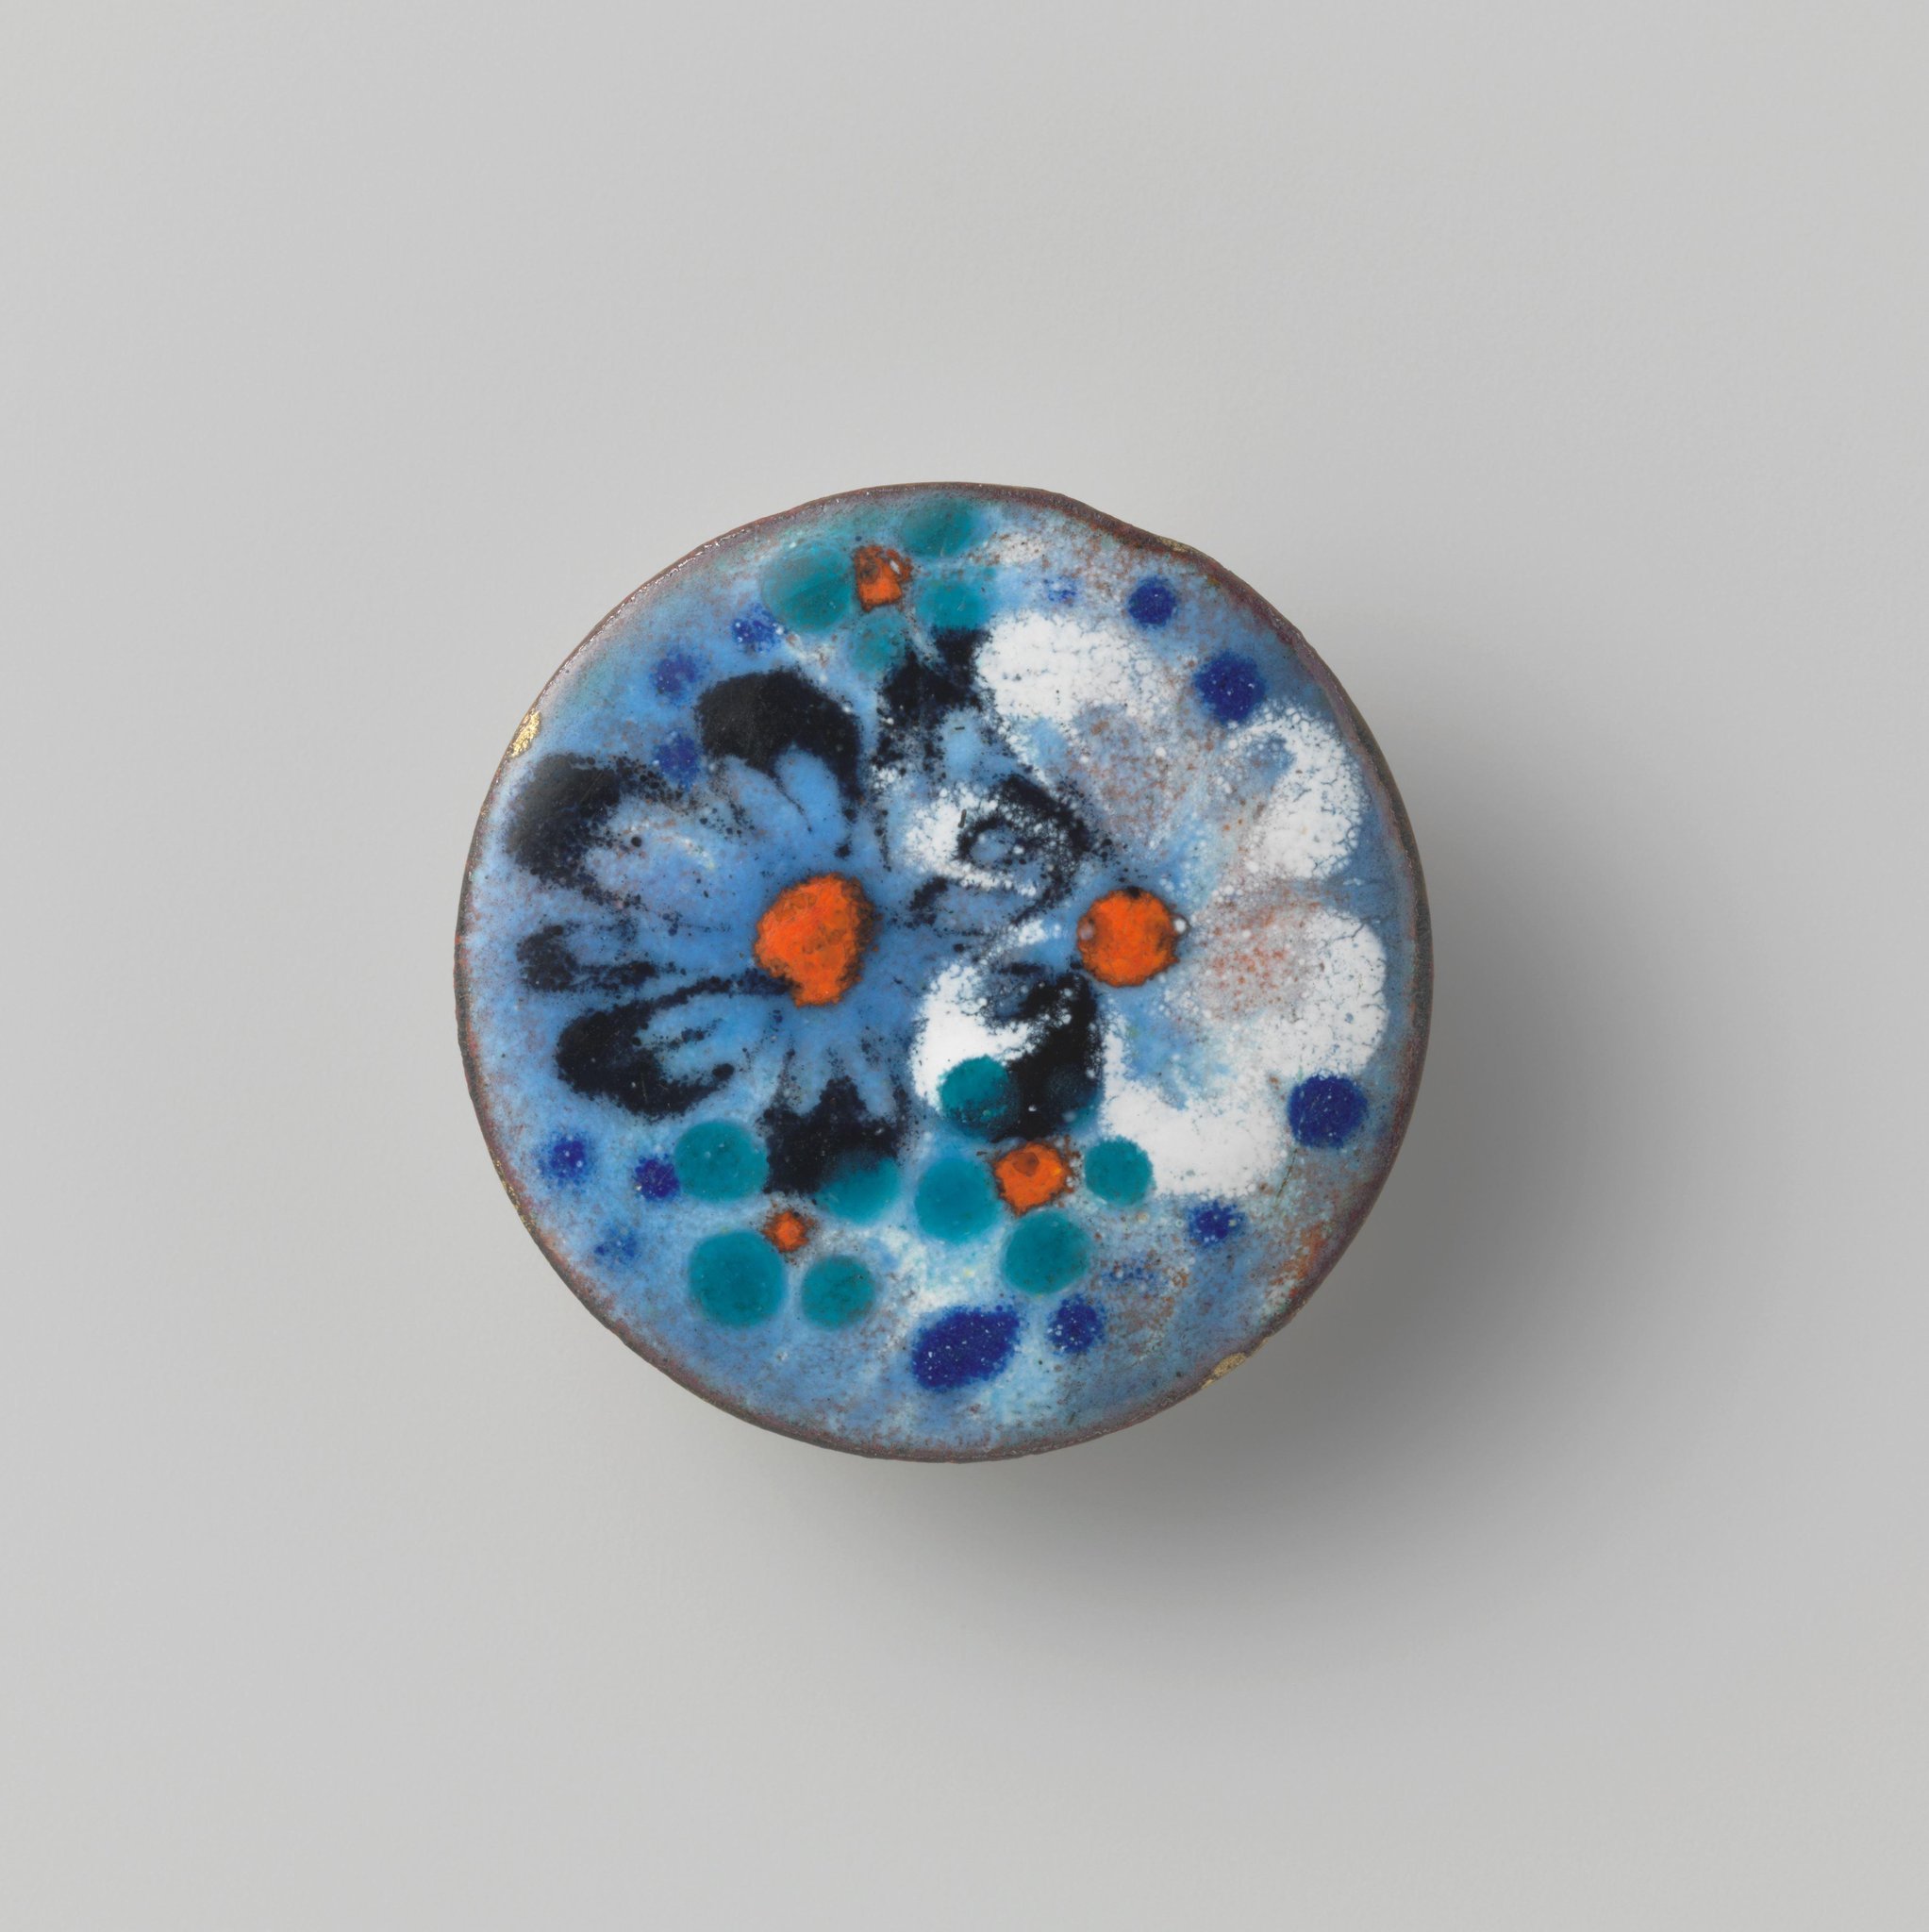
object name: brooch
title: Ronde broche van email op koper met bloemen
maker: Anonymous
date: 1950-1960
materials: copper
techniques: enameling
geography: netherlands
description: Ronde broche van email op koper voorzien van een kogelsluiting. De bloemen hebben een oranje hart, één bloem is wit en de ander is zwart op een blauw gevlekte achtergrond.